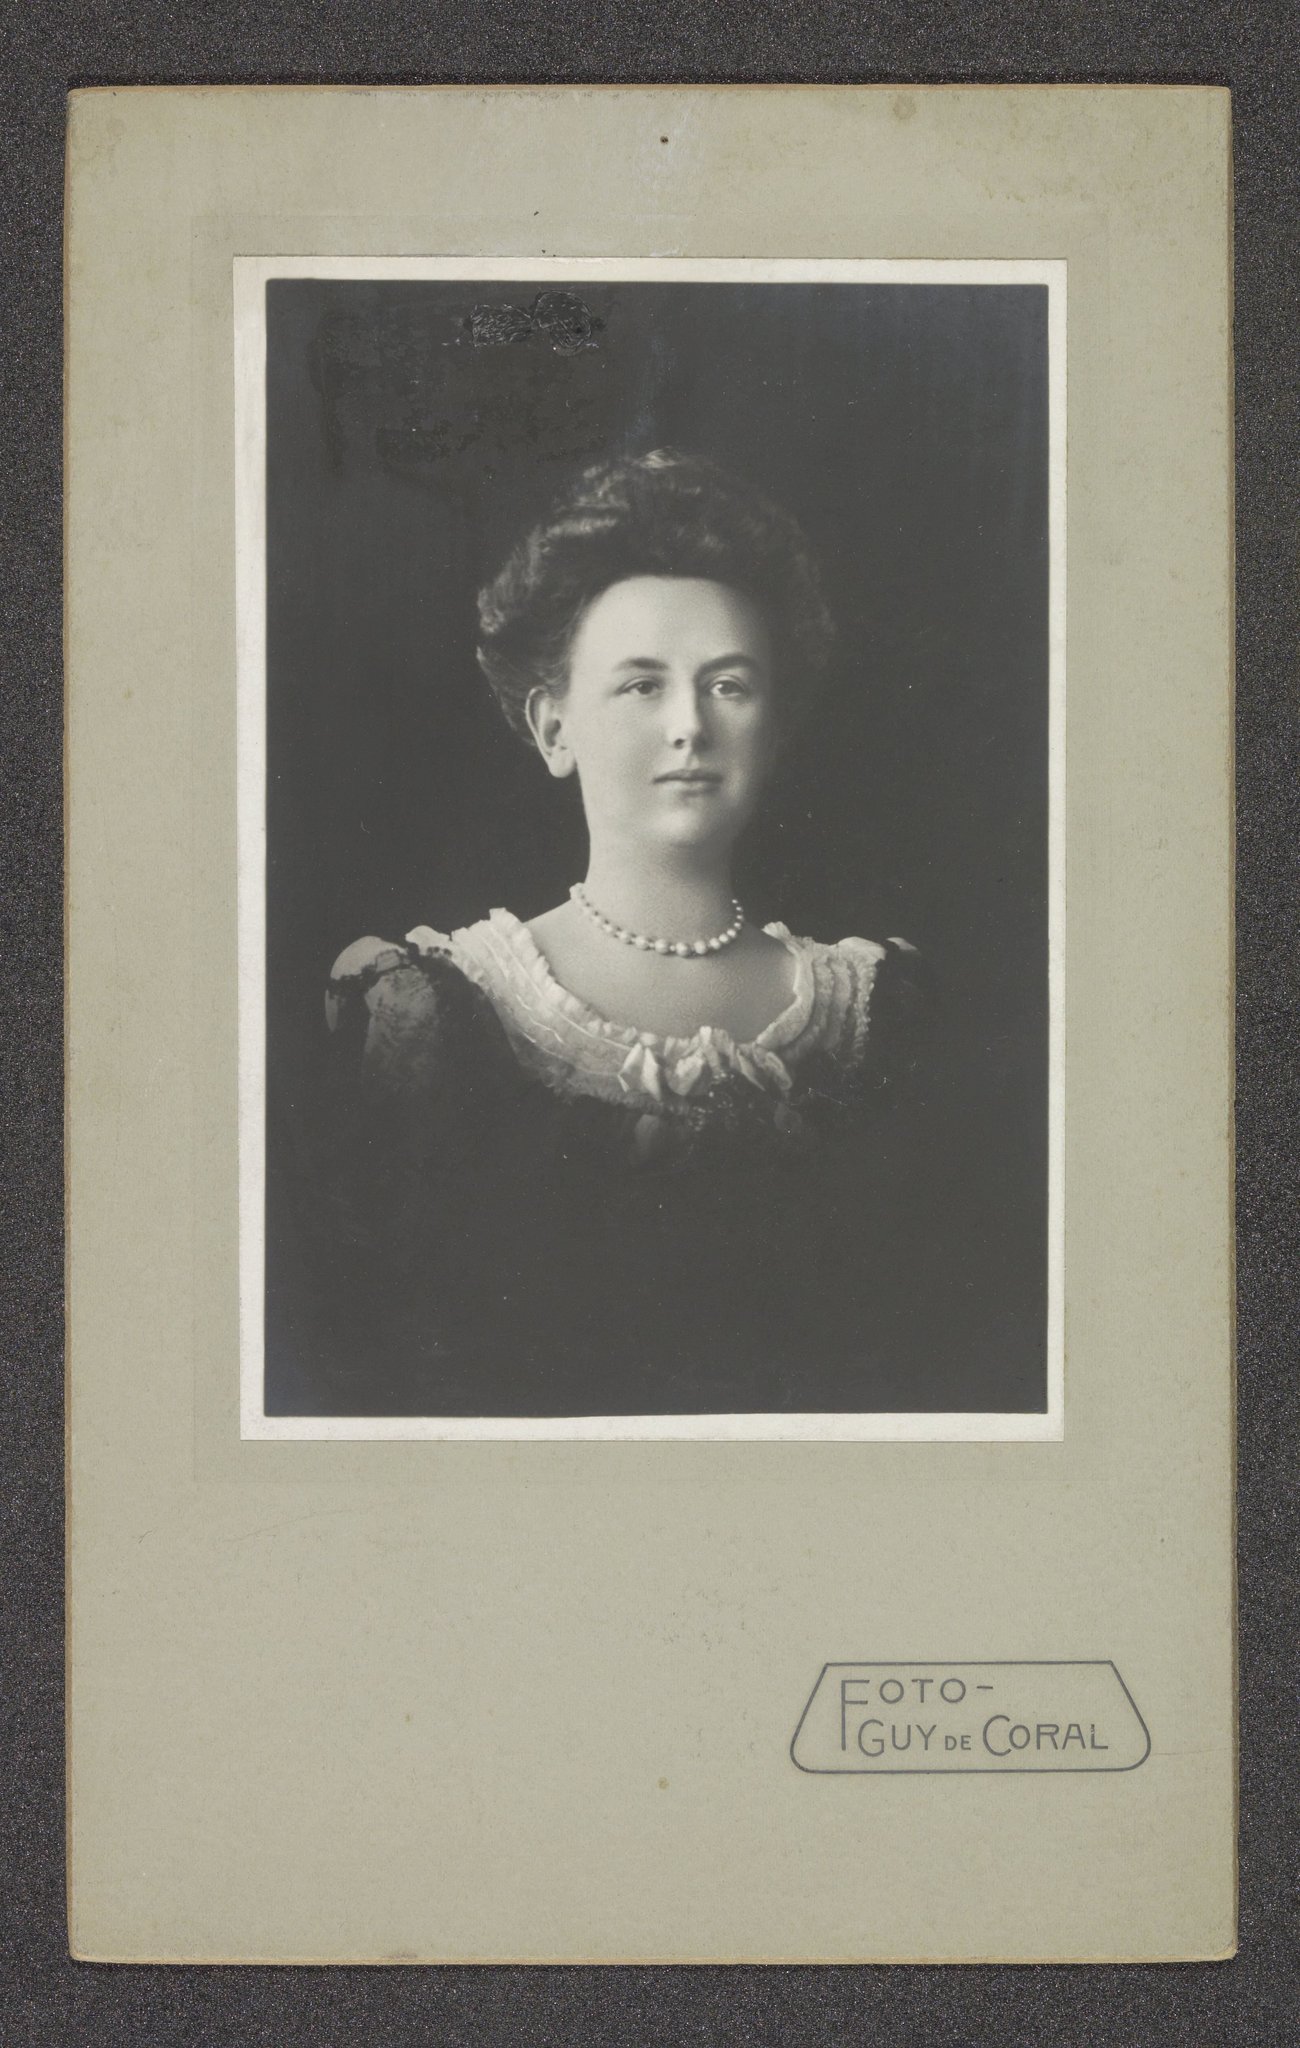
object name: photograph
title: Portret van een jonge Koningin Wilhelmina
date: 1895-1915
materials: photographic support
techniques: gelatin silver print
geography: amsterdam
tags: wilhelmina of the netherlands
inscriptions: name: ‘Origineele opname van Mij v/h Guy de Coral & Co foto artikelen Amsterdam Den Haag Groningen’